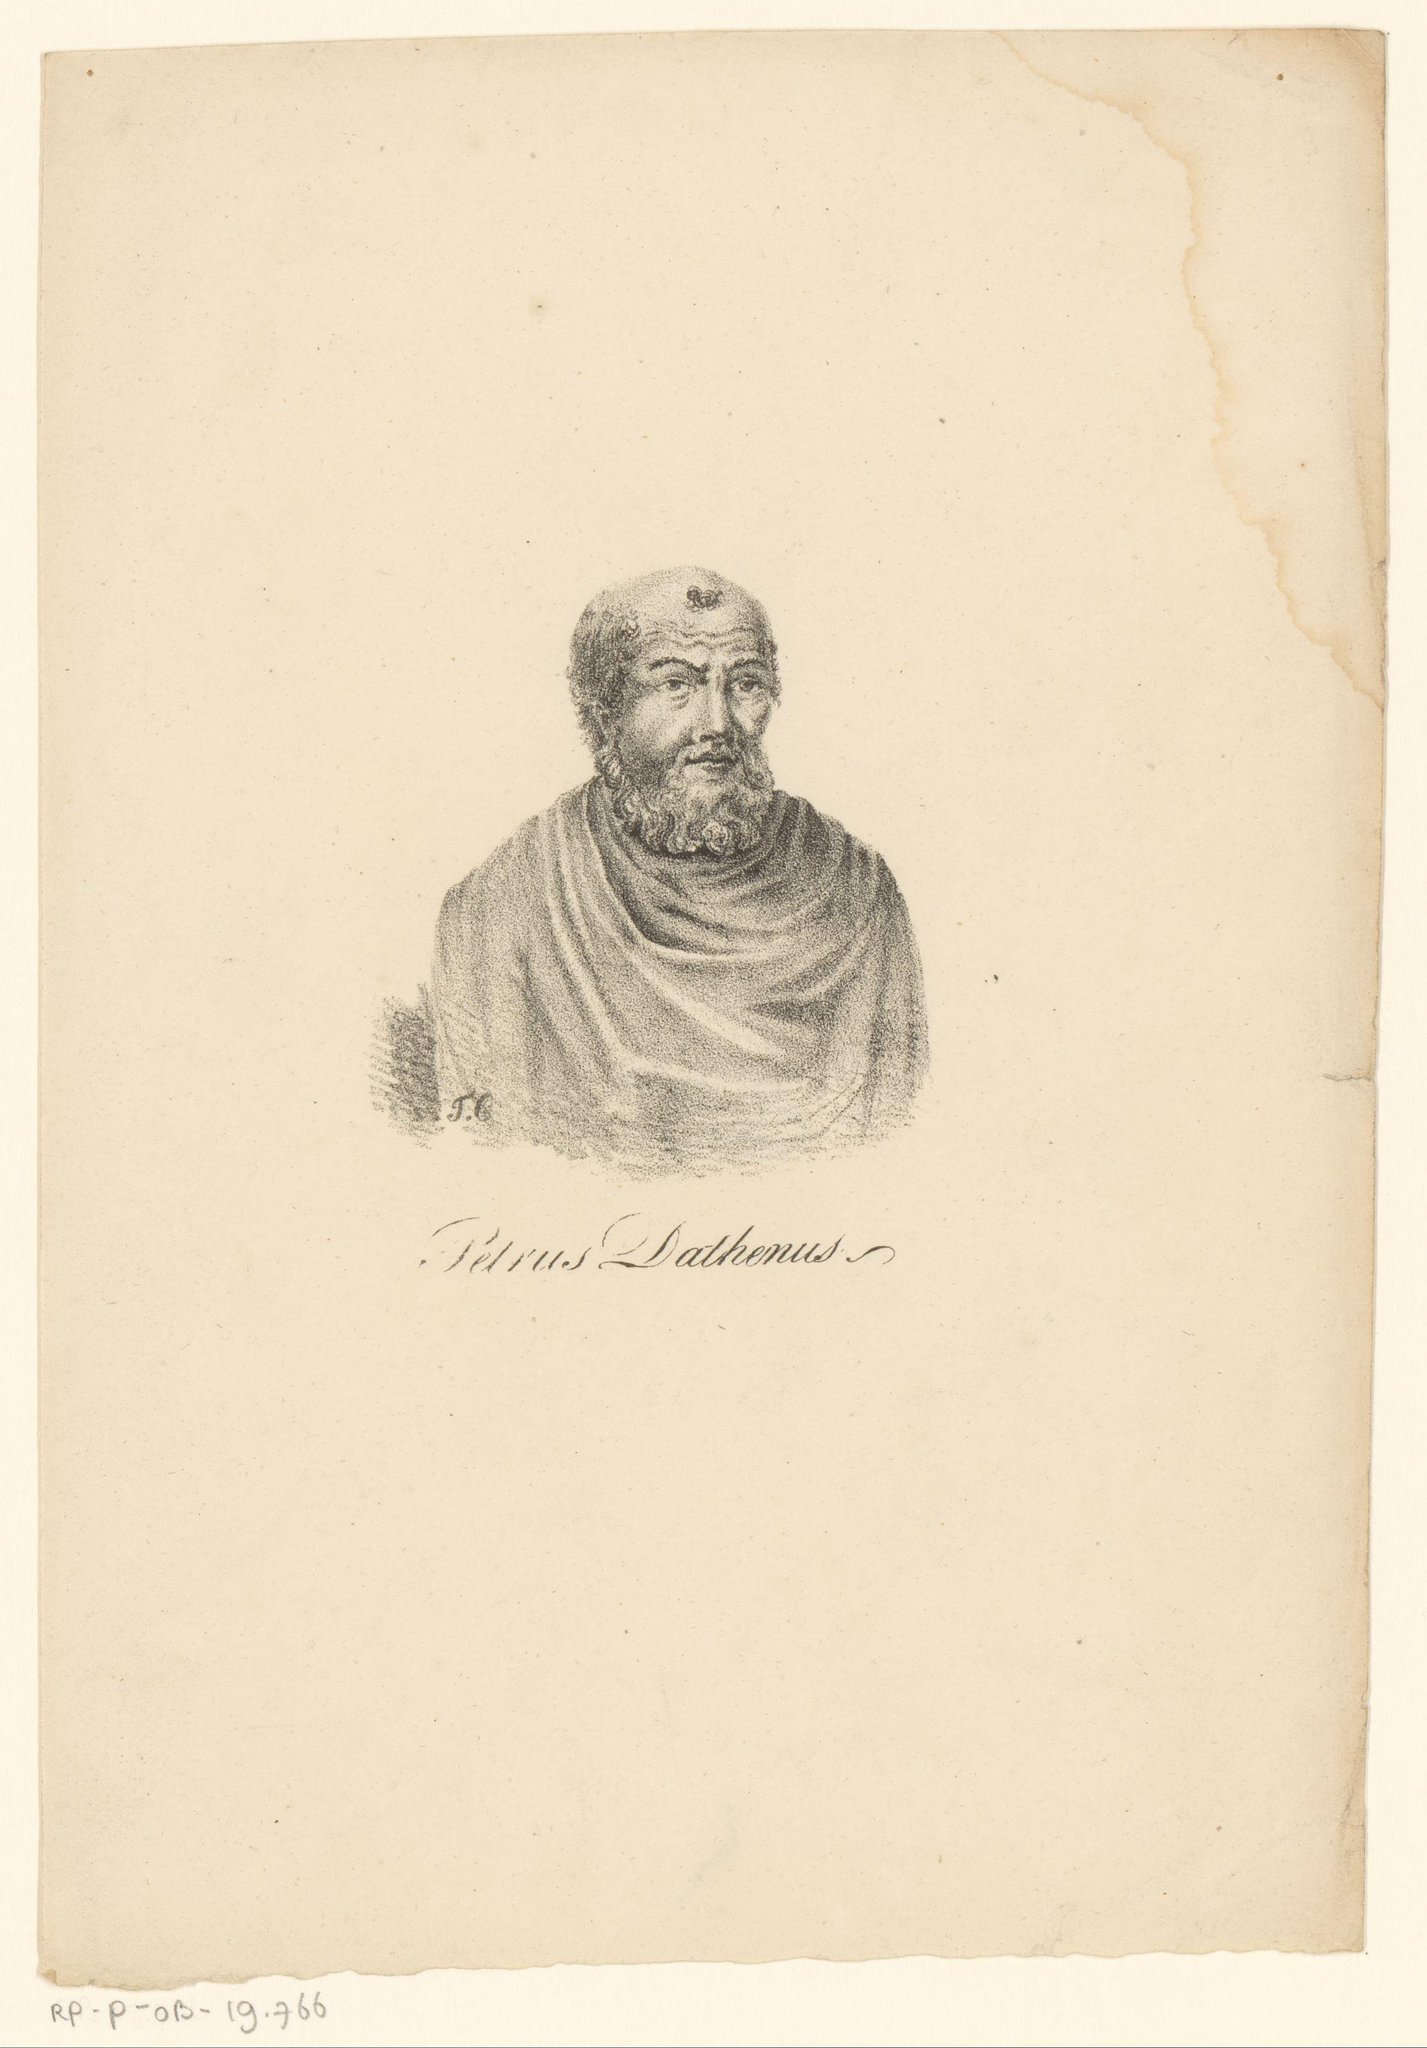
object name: print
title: Portret van Petrus Datheen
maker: Anonymous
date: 1809-1853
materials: paper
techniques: lithograph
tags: historical persons (+ (full) bust portrait)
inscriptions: monogram: ‘T.C.’, collector's mark: Lugt 2228